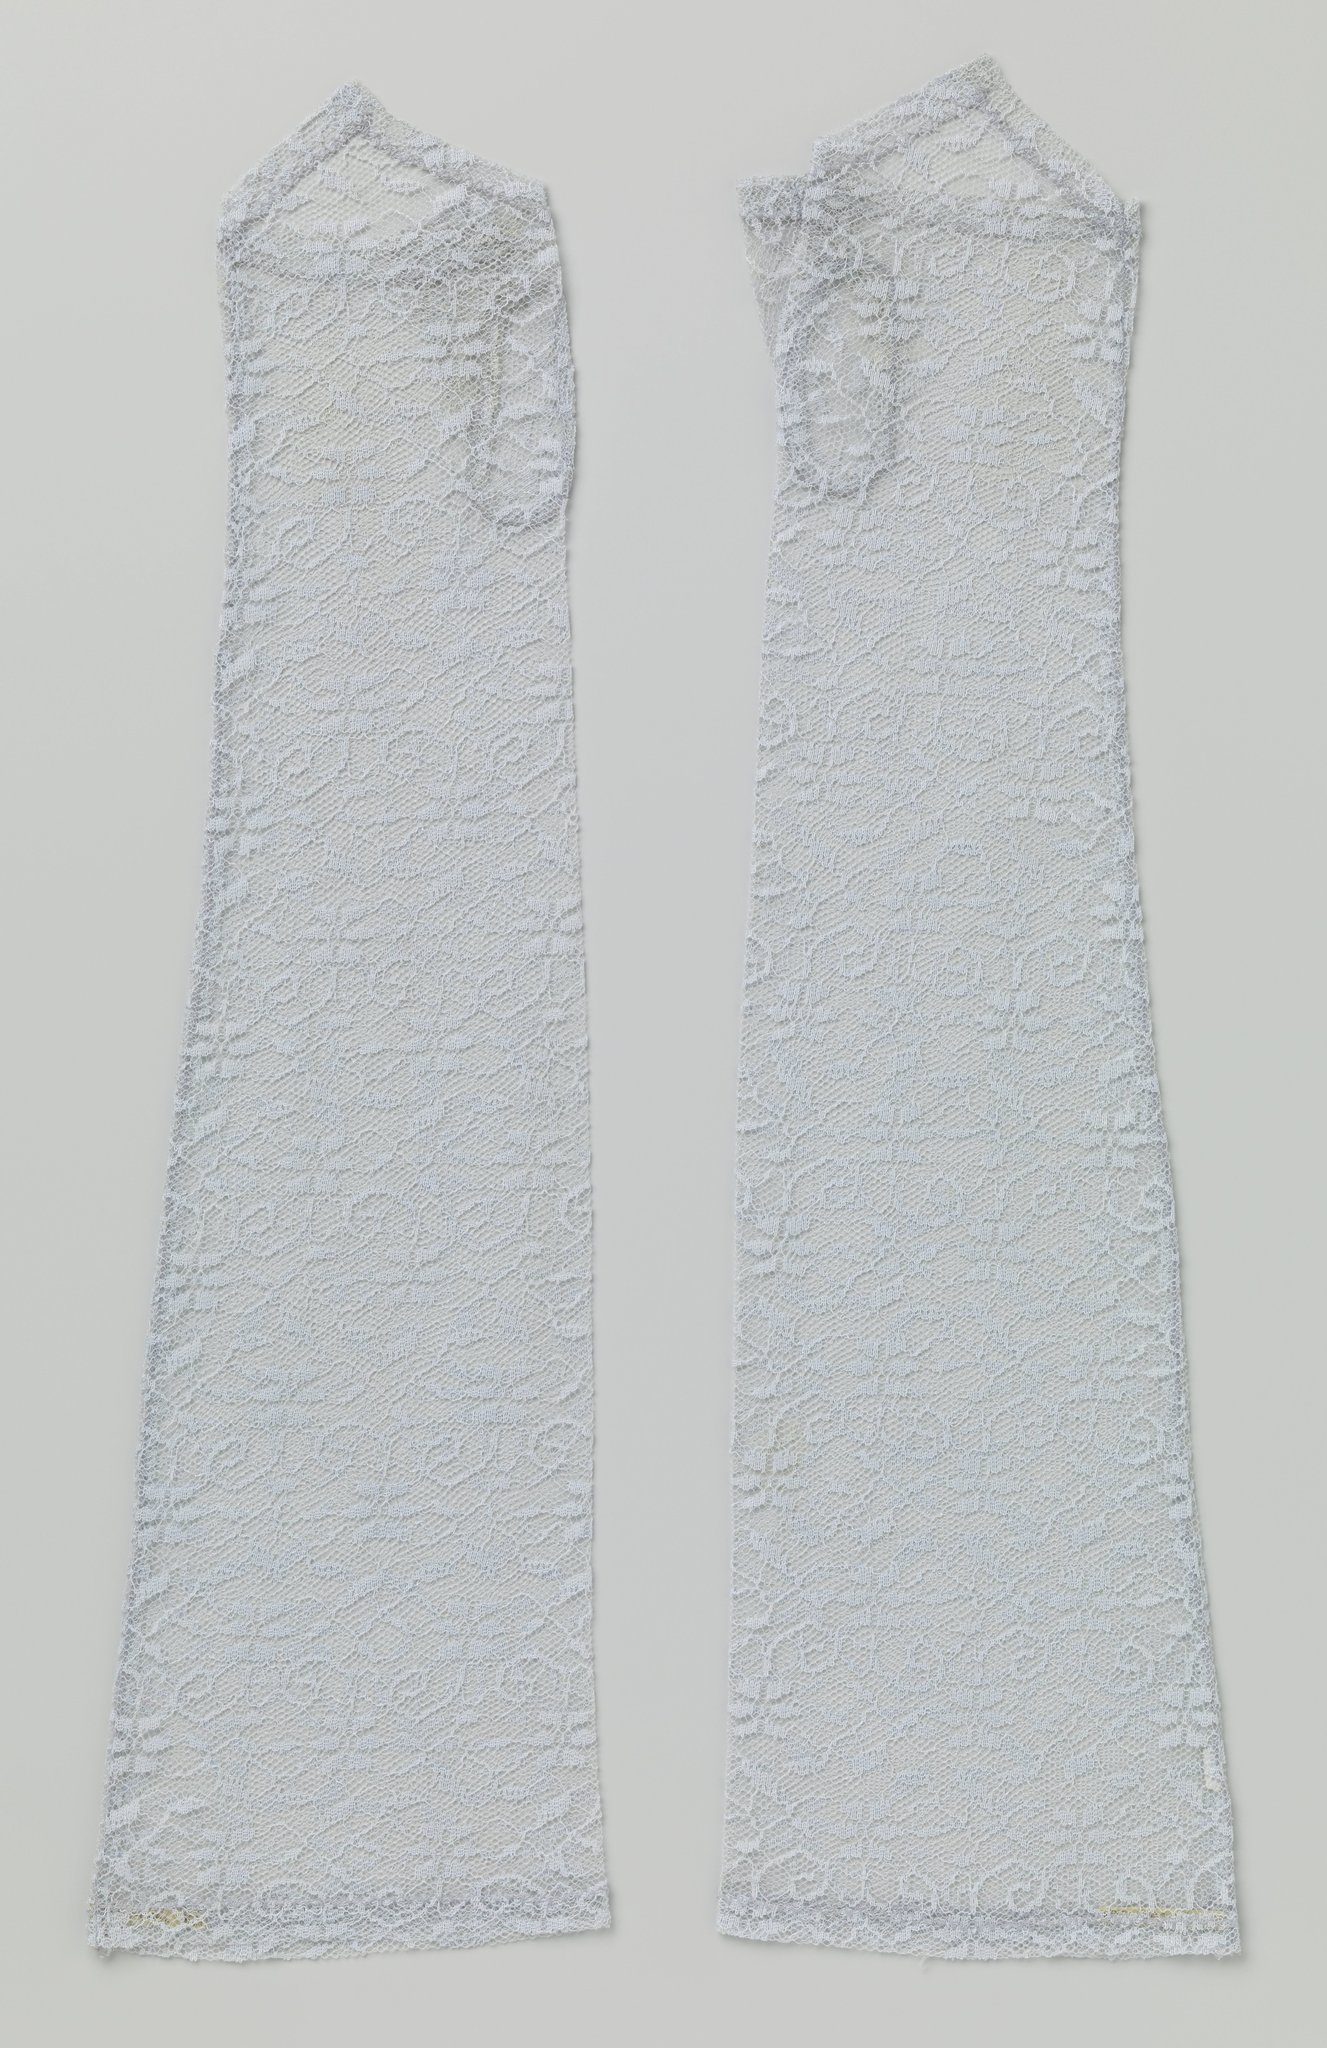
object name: mitt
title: Mitaine van machinale kant in blauw nylon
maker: Anonymous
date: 1955-1960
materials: cotton, plastic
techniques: weave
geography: netherlands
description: Rechtermitaine in blauw nylon. Uit machinaal vervaardigd kant met bloempatroon.